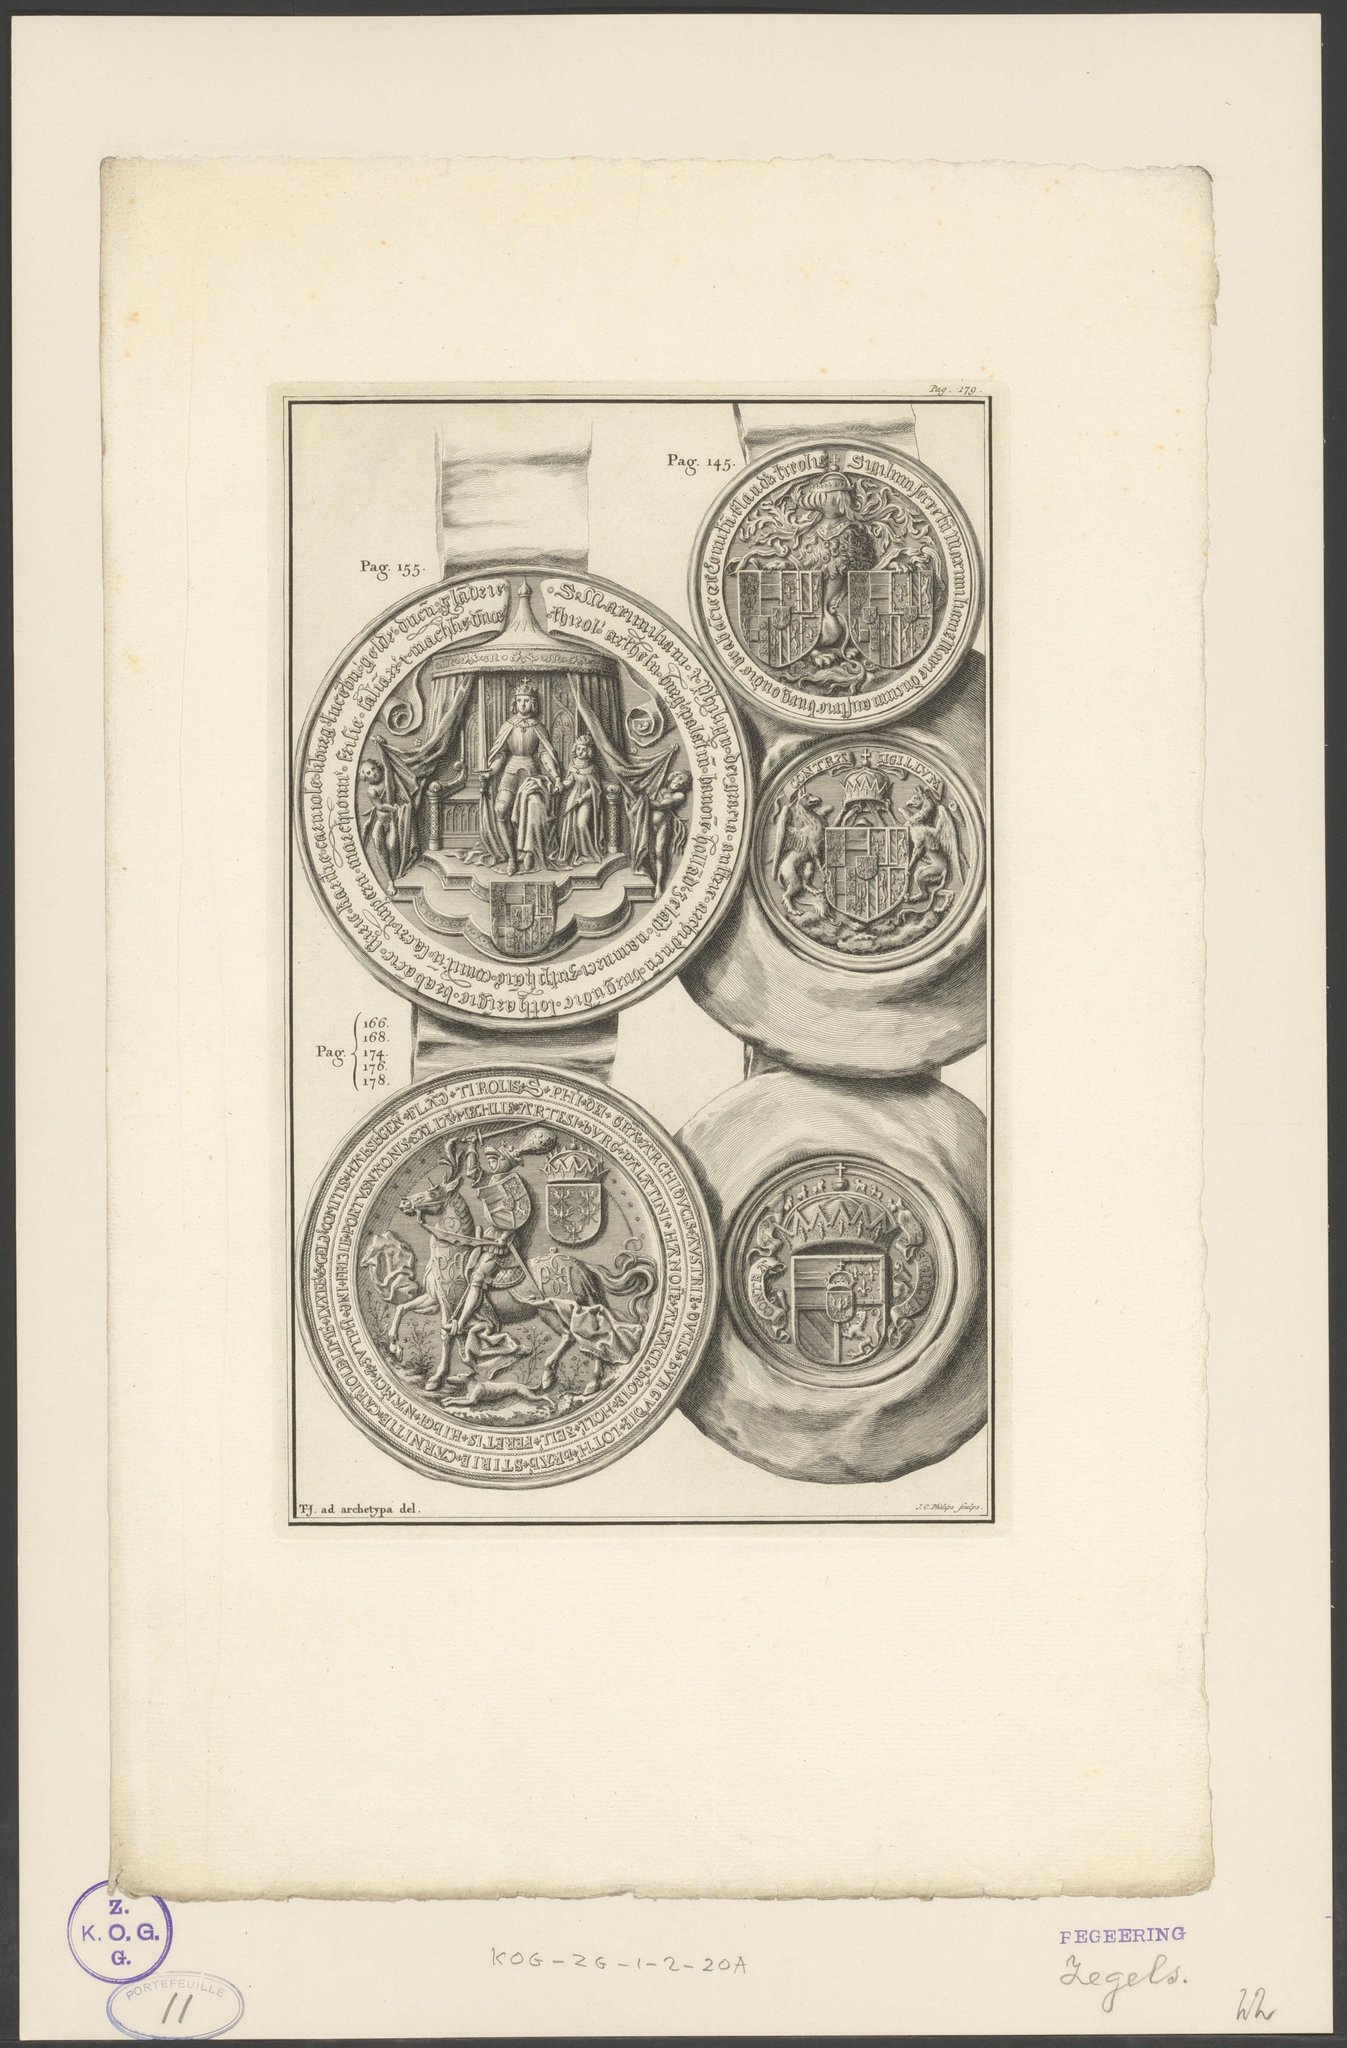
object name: book illustration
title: Blad met zegels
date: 1751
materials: paper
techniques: engraving, etching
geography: netherlands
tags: seal, stamp, seal (as symbol of the state, etc.)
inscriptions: collector's mark, collector's mark: Lugt 1641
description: Diverse zegels, Pag. 179. Met verwijzingen naar andere nummers en paginanummers. Onderwerpsrubrieken binnen de Atlas Zeden en Gewoonten: Regeering, Zegels.